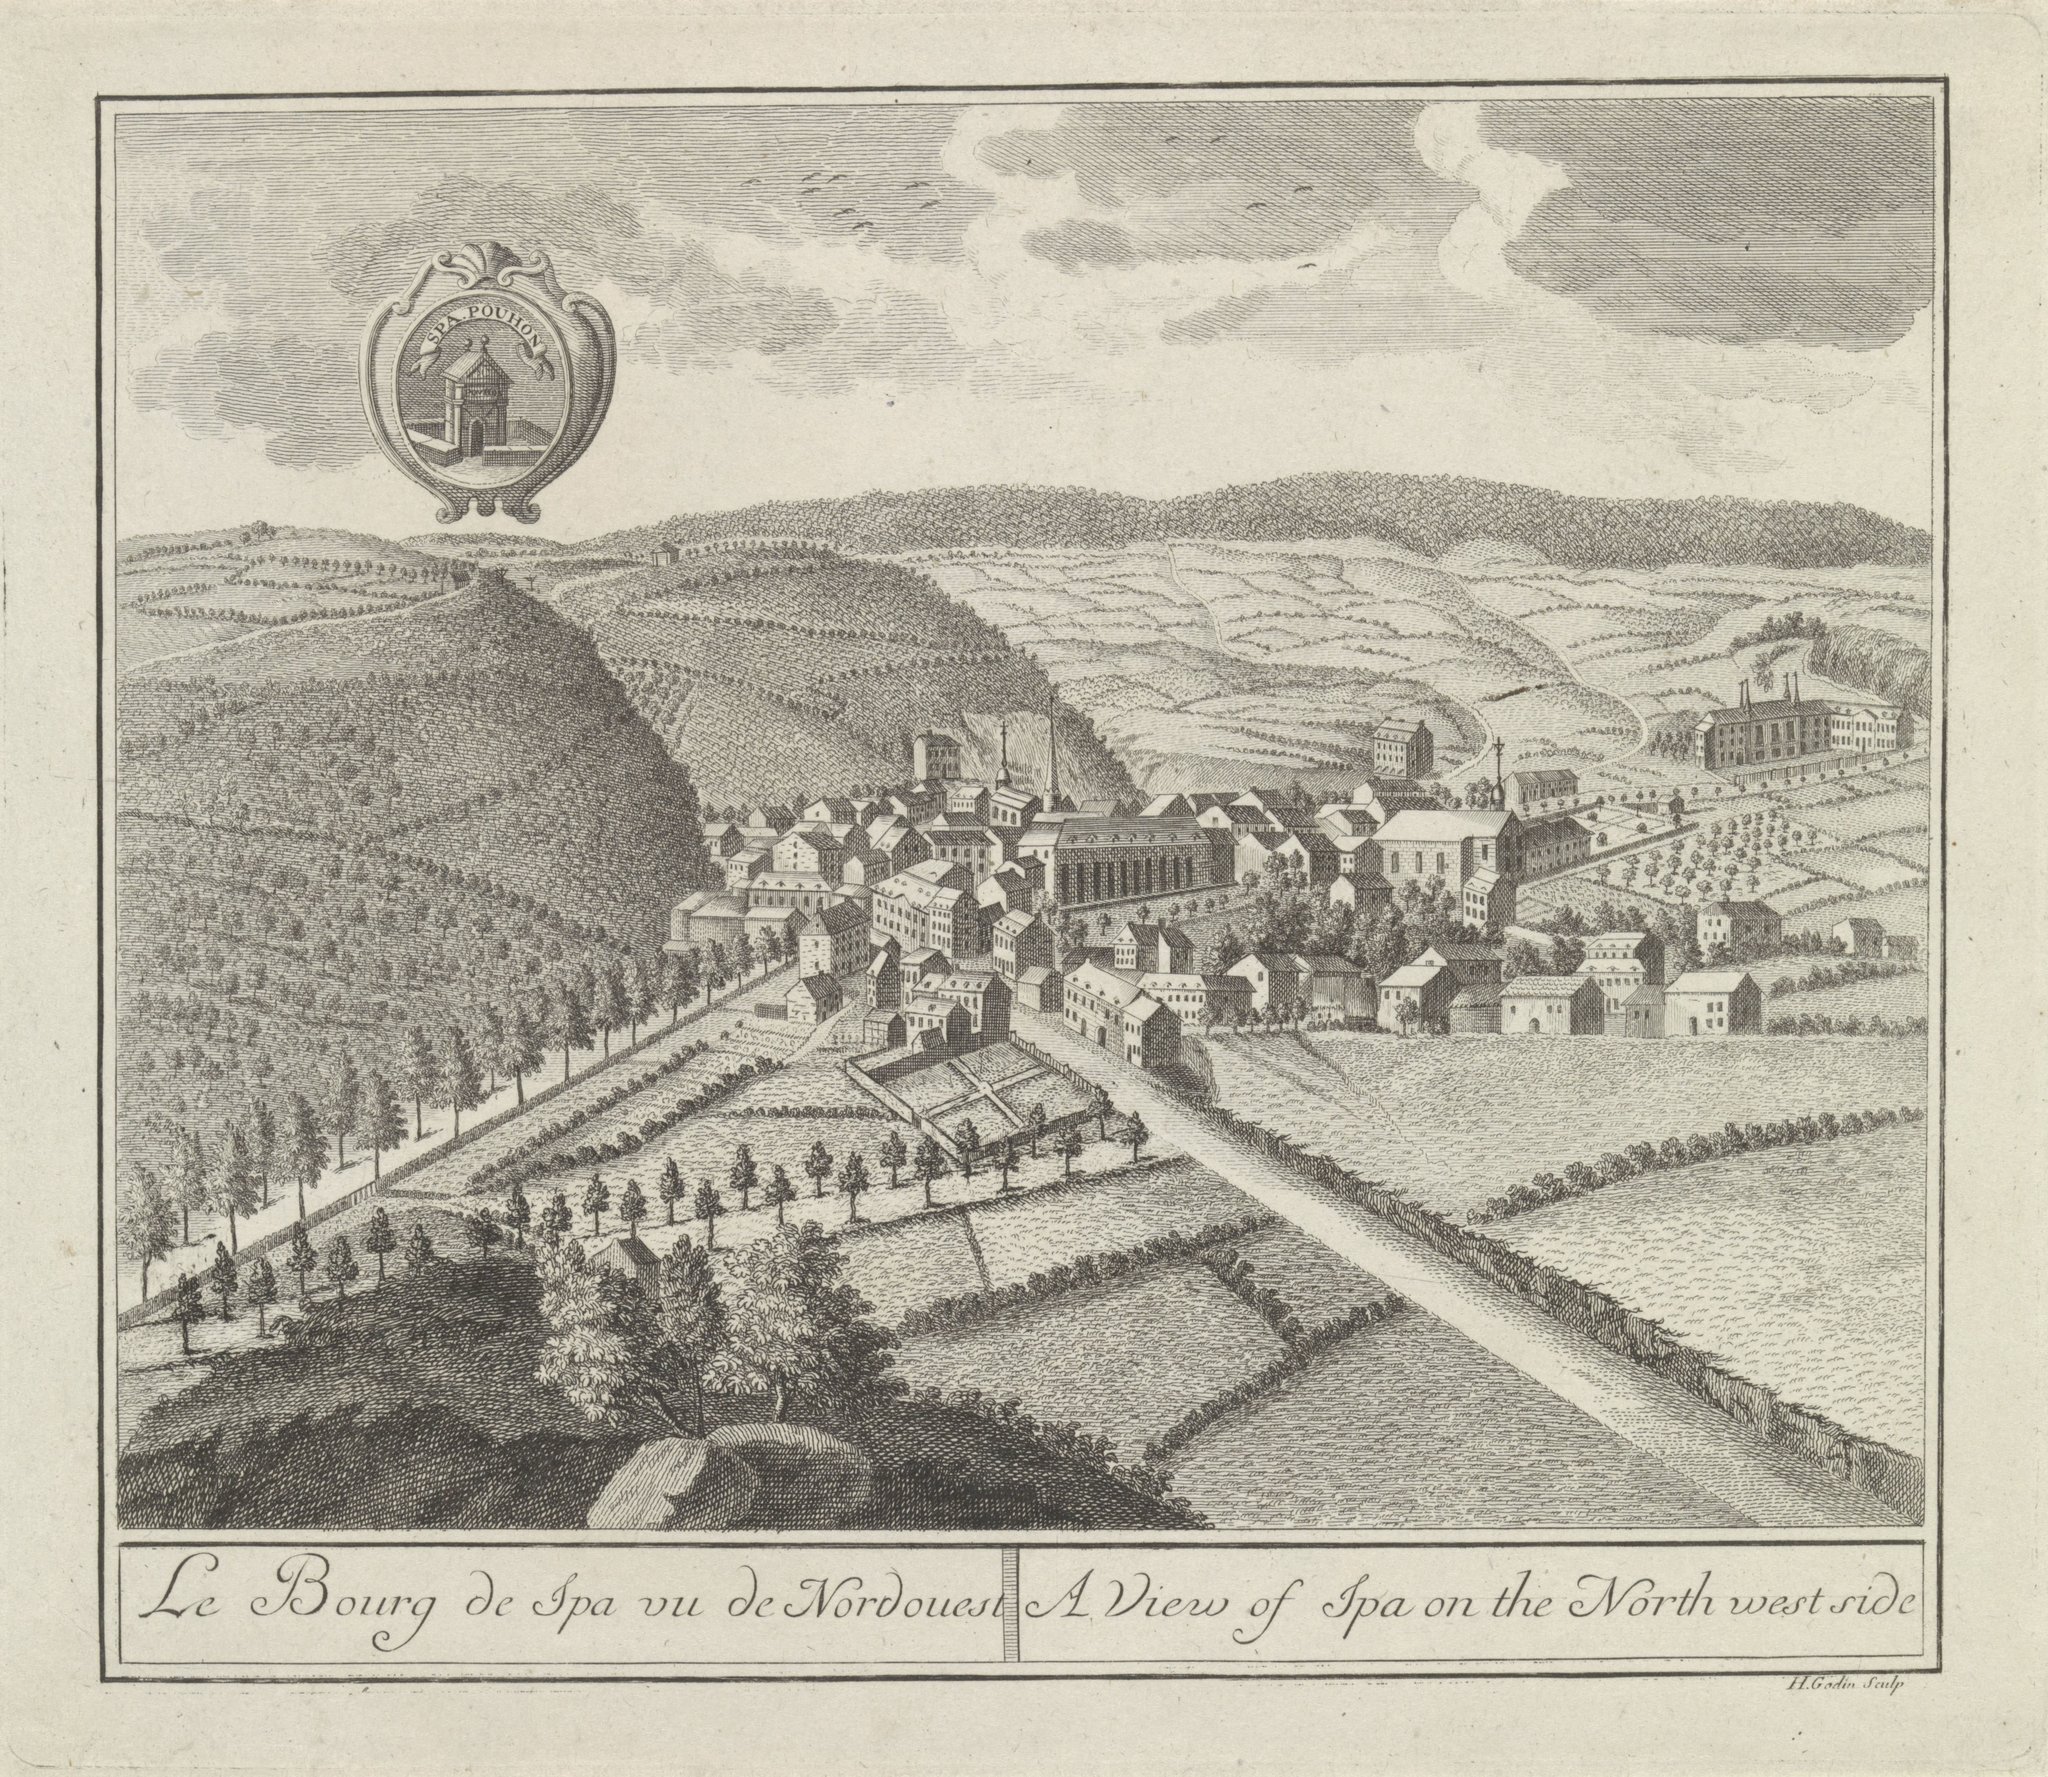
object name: print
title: Gezichten in en nabij Spa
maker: henri-joseph godin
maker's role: print maker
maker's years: 1747-1834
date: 1778-1782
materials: paper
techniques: engraving, etching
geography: liège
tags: spa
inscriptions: collector's mark: Lugt 2228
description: Gezicht op Spa vanuit het noordwesten. Rechtsboven het wapenschild van Spa. De prent is deel van een serie met landschappen in en nabij Spa